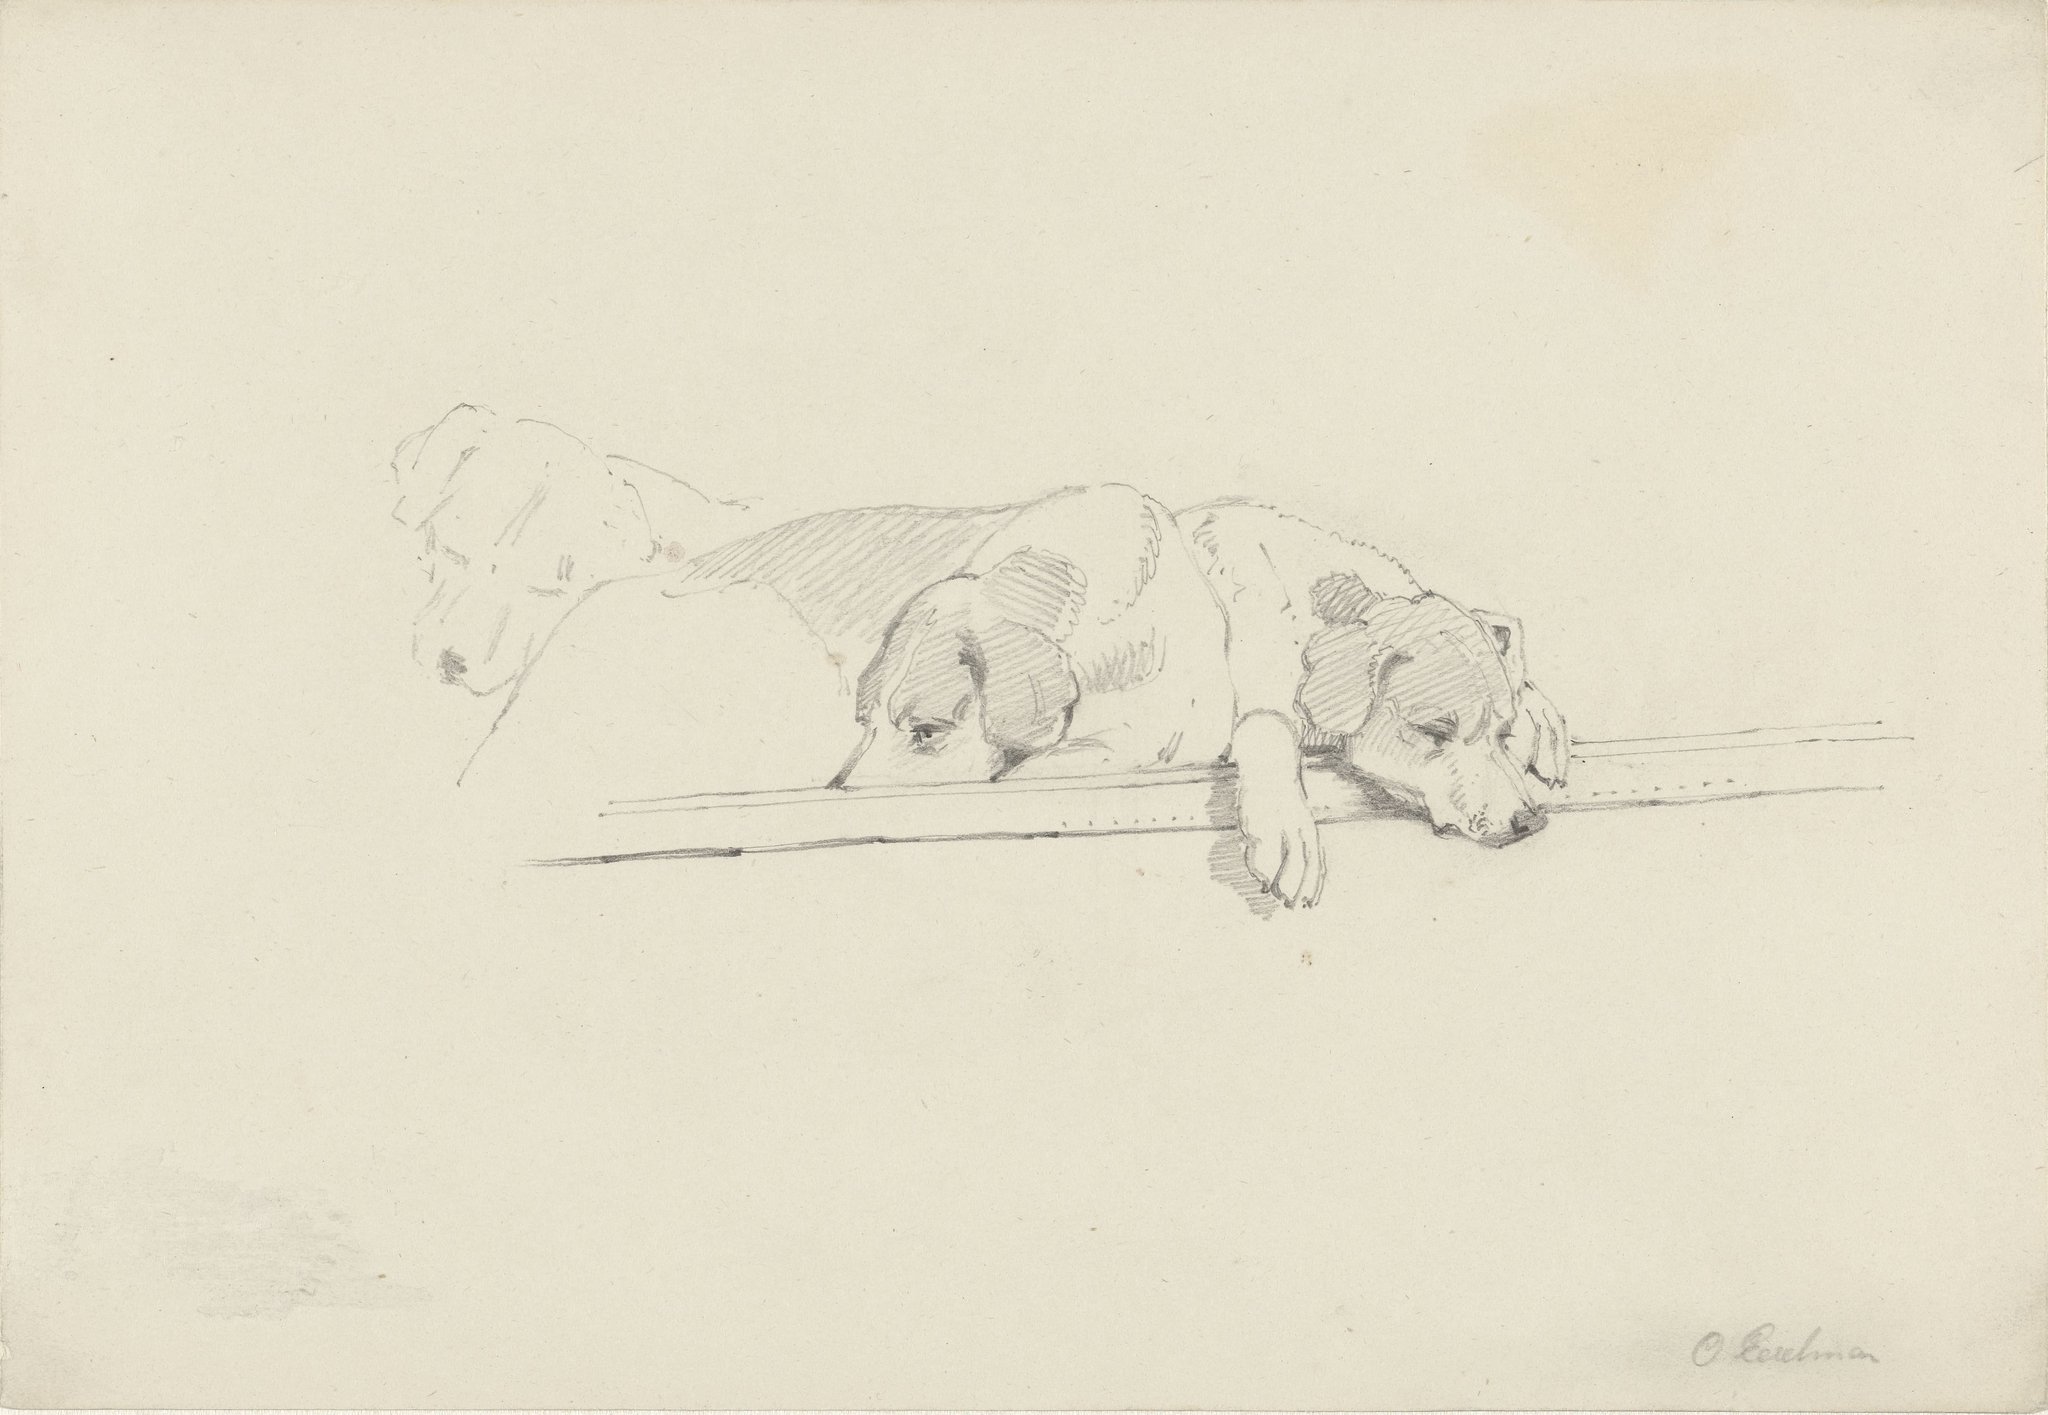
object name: drawing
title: Schets van drie slapende honden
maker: otto eerelman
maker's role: draughtsman, painter, print maker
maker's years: 1839-1926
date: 1849-1926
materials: paper, pencil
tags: dog